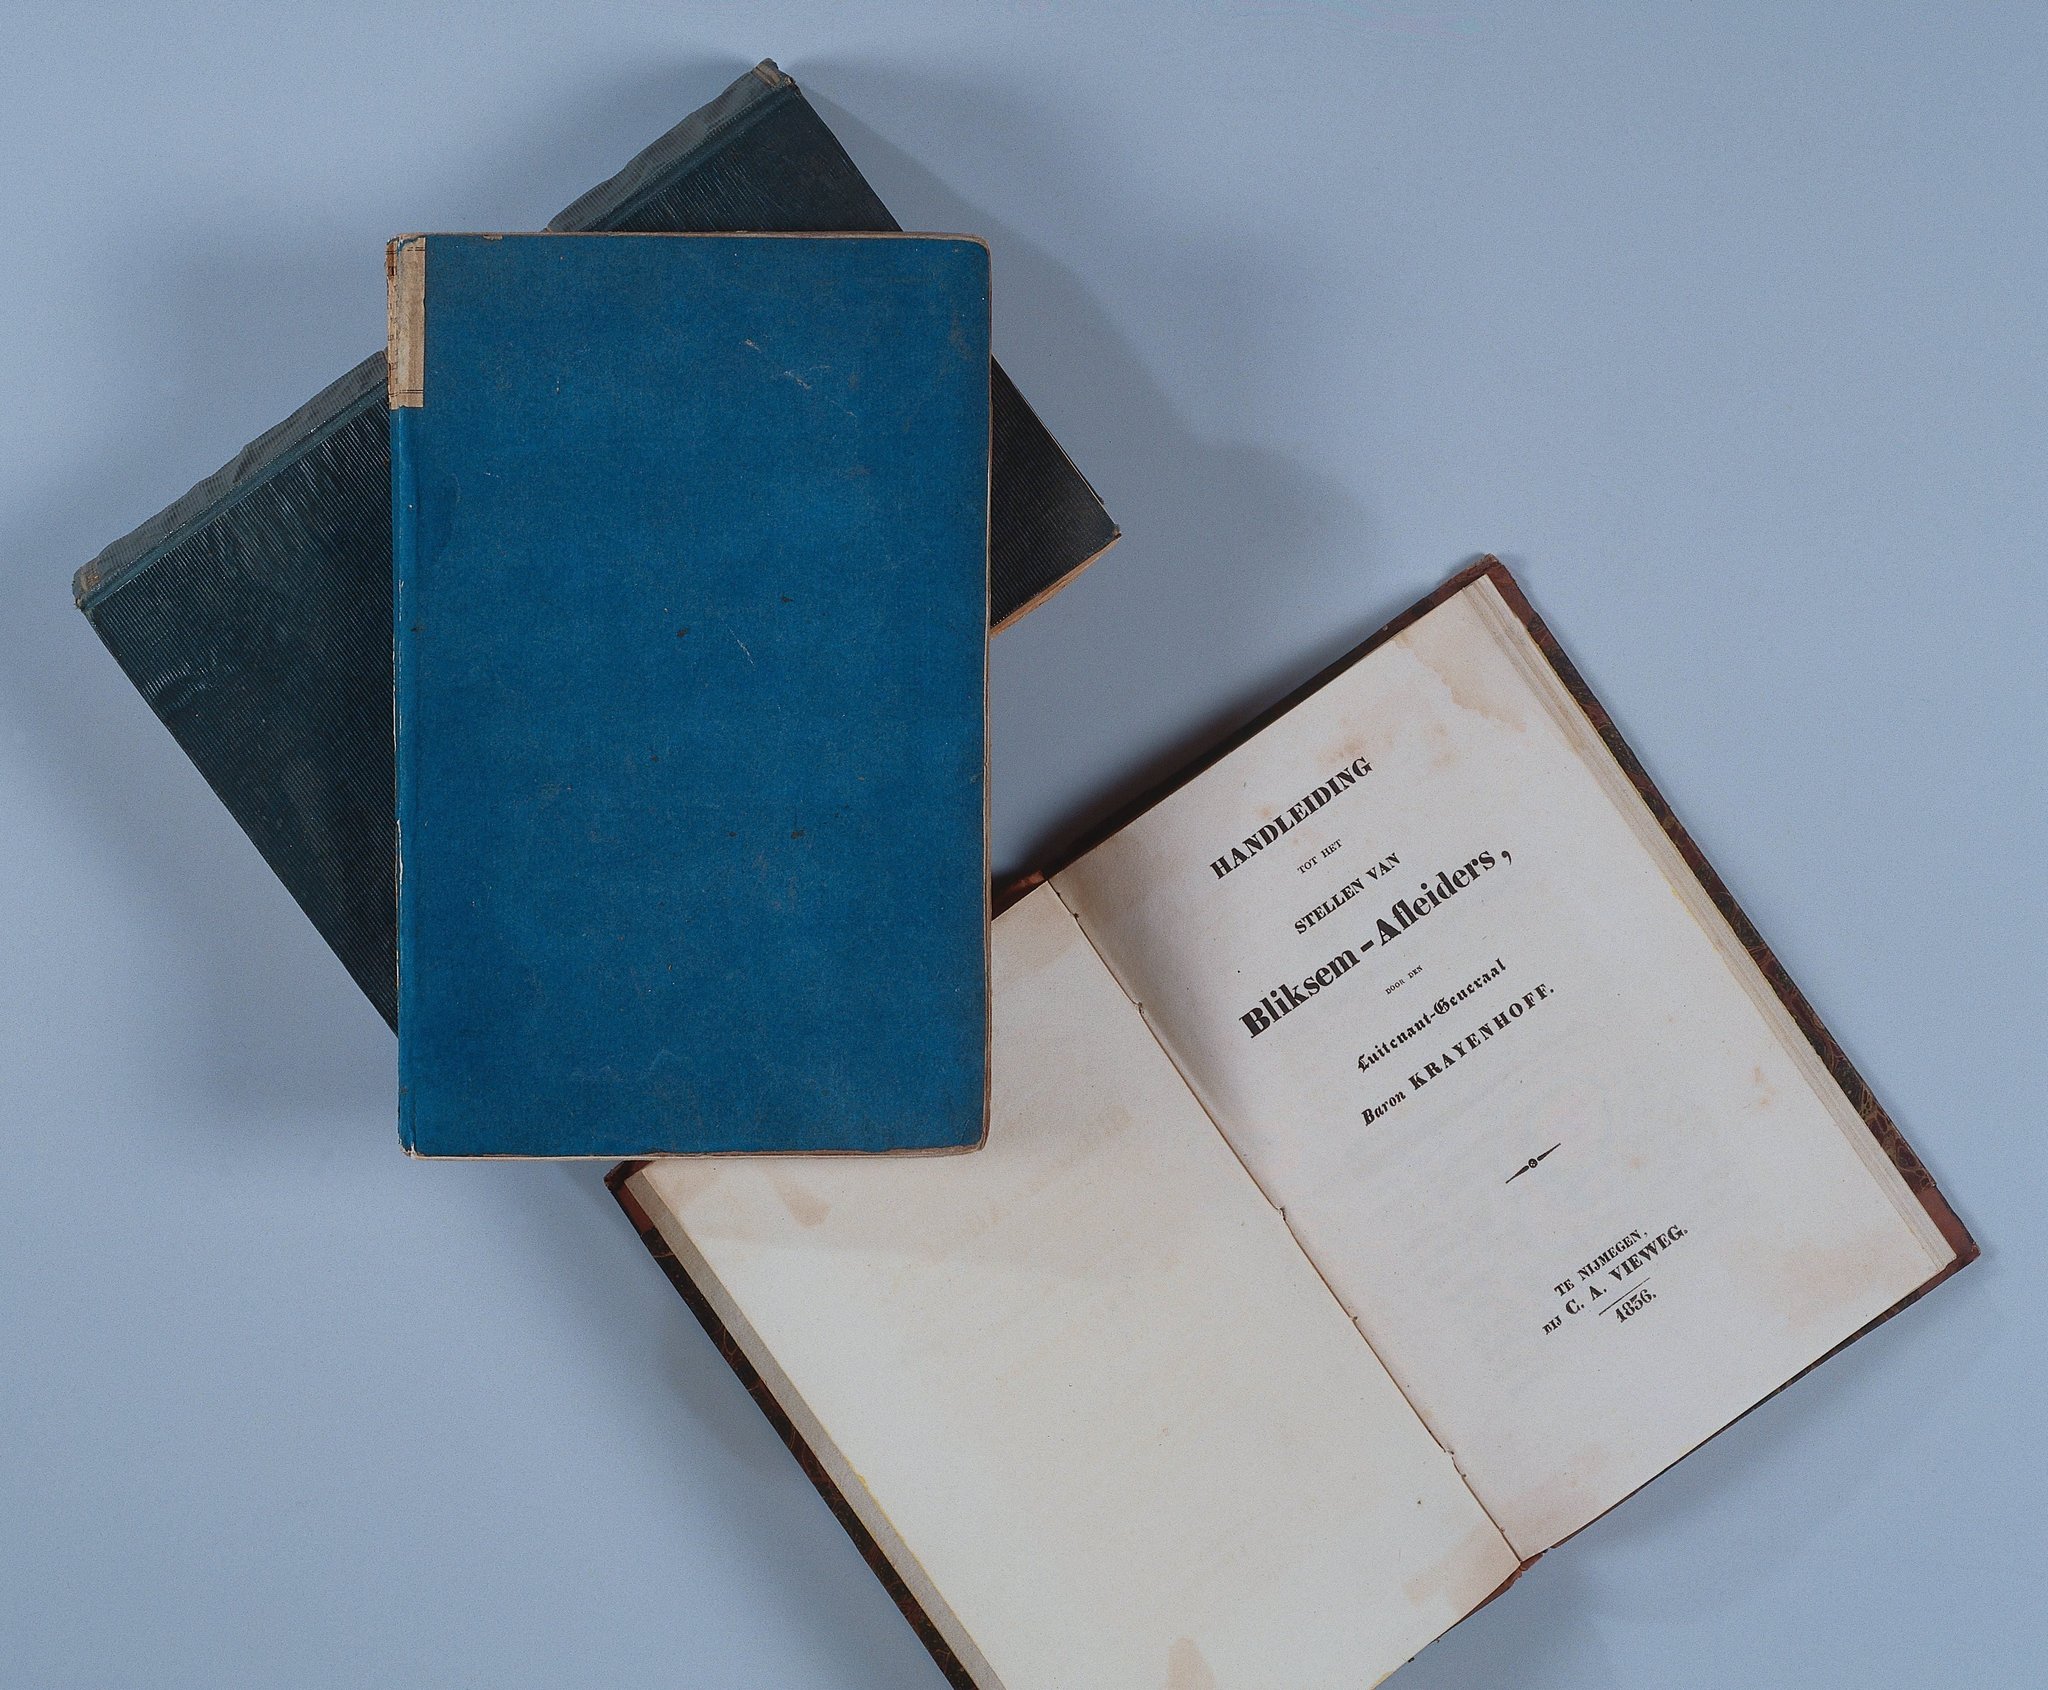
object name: book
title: Handleiding tot het stellen van Bliksem-Afleiders en Bijdragen over Afleiders en Het Onweder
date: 1836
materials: cardboard, paper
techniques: letterpress printing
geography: nijmegen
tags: nijmegen, physicist, cornelis rudolphus theodorus krayenhoff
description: Handleiding tot het stellen van Bliksem-Afleiders en Bijdragen over Afleiders en Het Onweder, samen in 1 band gebonden. het eerste deel bestaat uit een voorwoord van schrijver Kraijenhoff aan Baron van Heeckeren van Kell, 61 pagina's verhandeling over bliksemafleiders, naschrift en een uitklaptekening met bevestiging van bliksemafleiders op een molen en een kerk, en de diverse onderdelen van een bliksemafleider. Tweede deel bestaat uit 31 pagina's en is overgenomen uit de Algemeenen Konst en Letterbode, 1836, nummer 21, 22, 36 en 50.